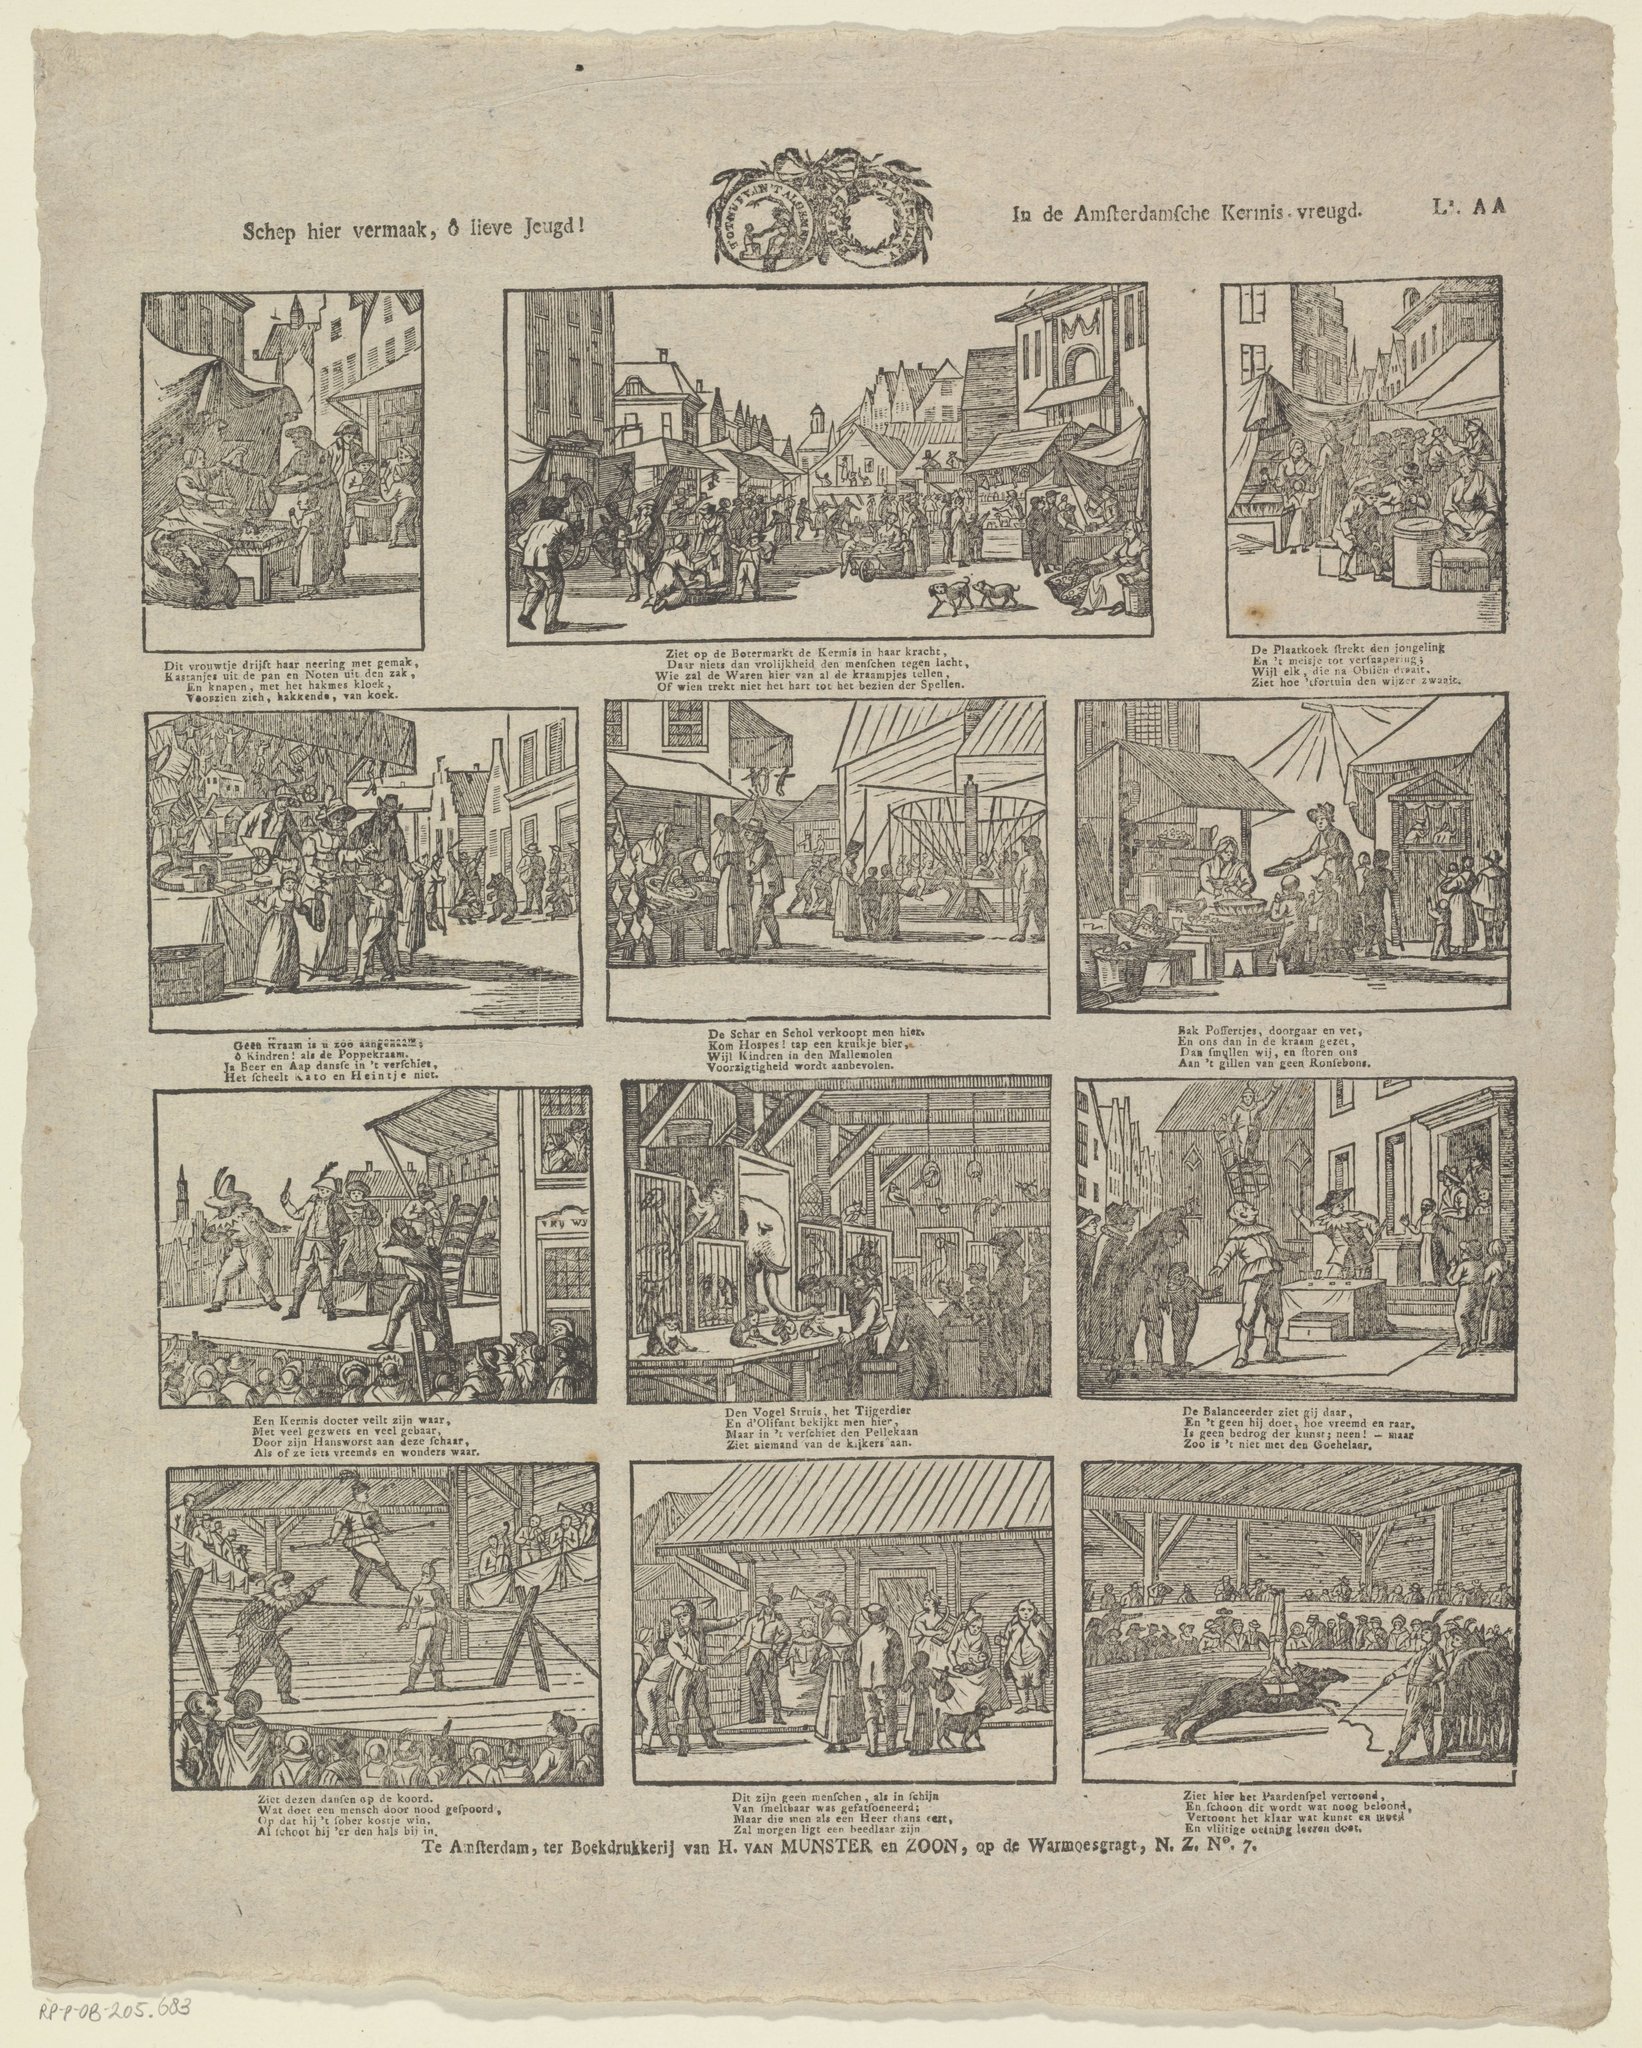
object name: popular print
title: Schep hier vermaak, ô lieve jeugd! / In de Amsterdamsche kermis-vreugd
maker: Anonymous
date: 1811-1829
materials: paper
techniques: letterpress printing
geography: amsterdam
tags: (annual) fair, trade fair, pleasure fair and circus, amsterdam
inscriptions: collector's mark: Lugt 2760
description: Blad met 12 voorstellingen van de attracties, kramen, voorstellingen en bezienswaardigheden op de Amsterdamse kermis. Midden boven het zegel van de Maatschappij tot Nut van 't Algemeen. Onder elke afbeelding een vierregelig vers. Genummerd rechtsboven: L.AA.